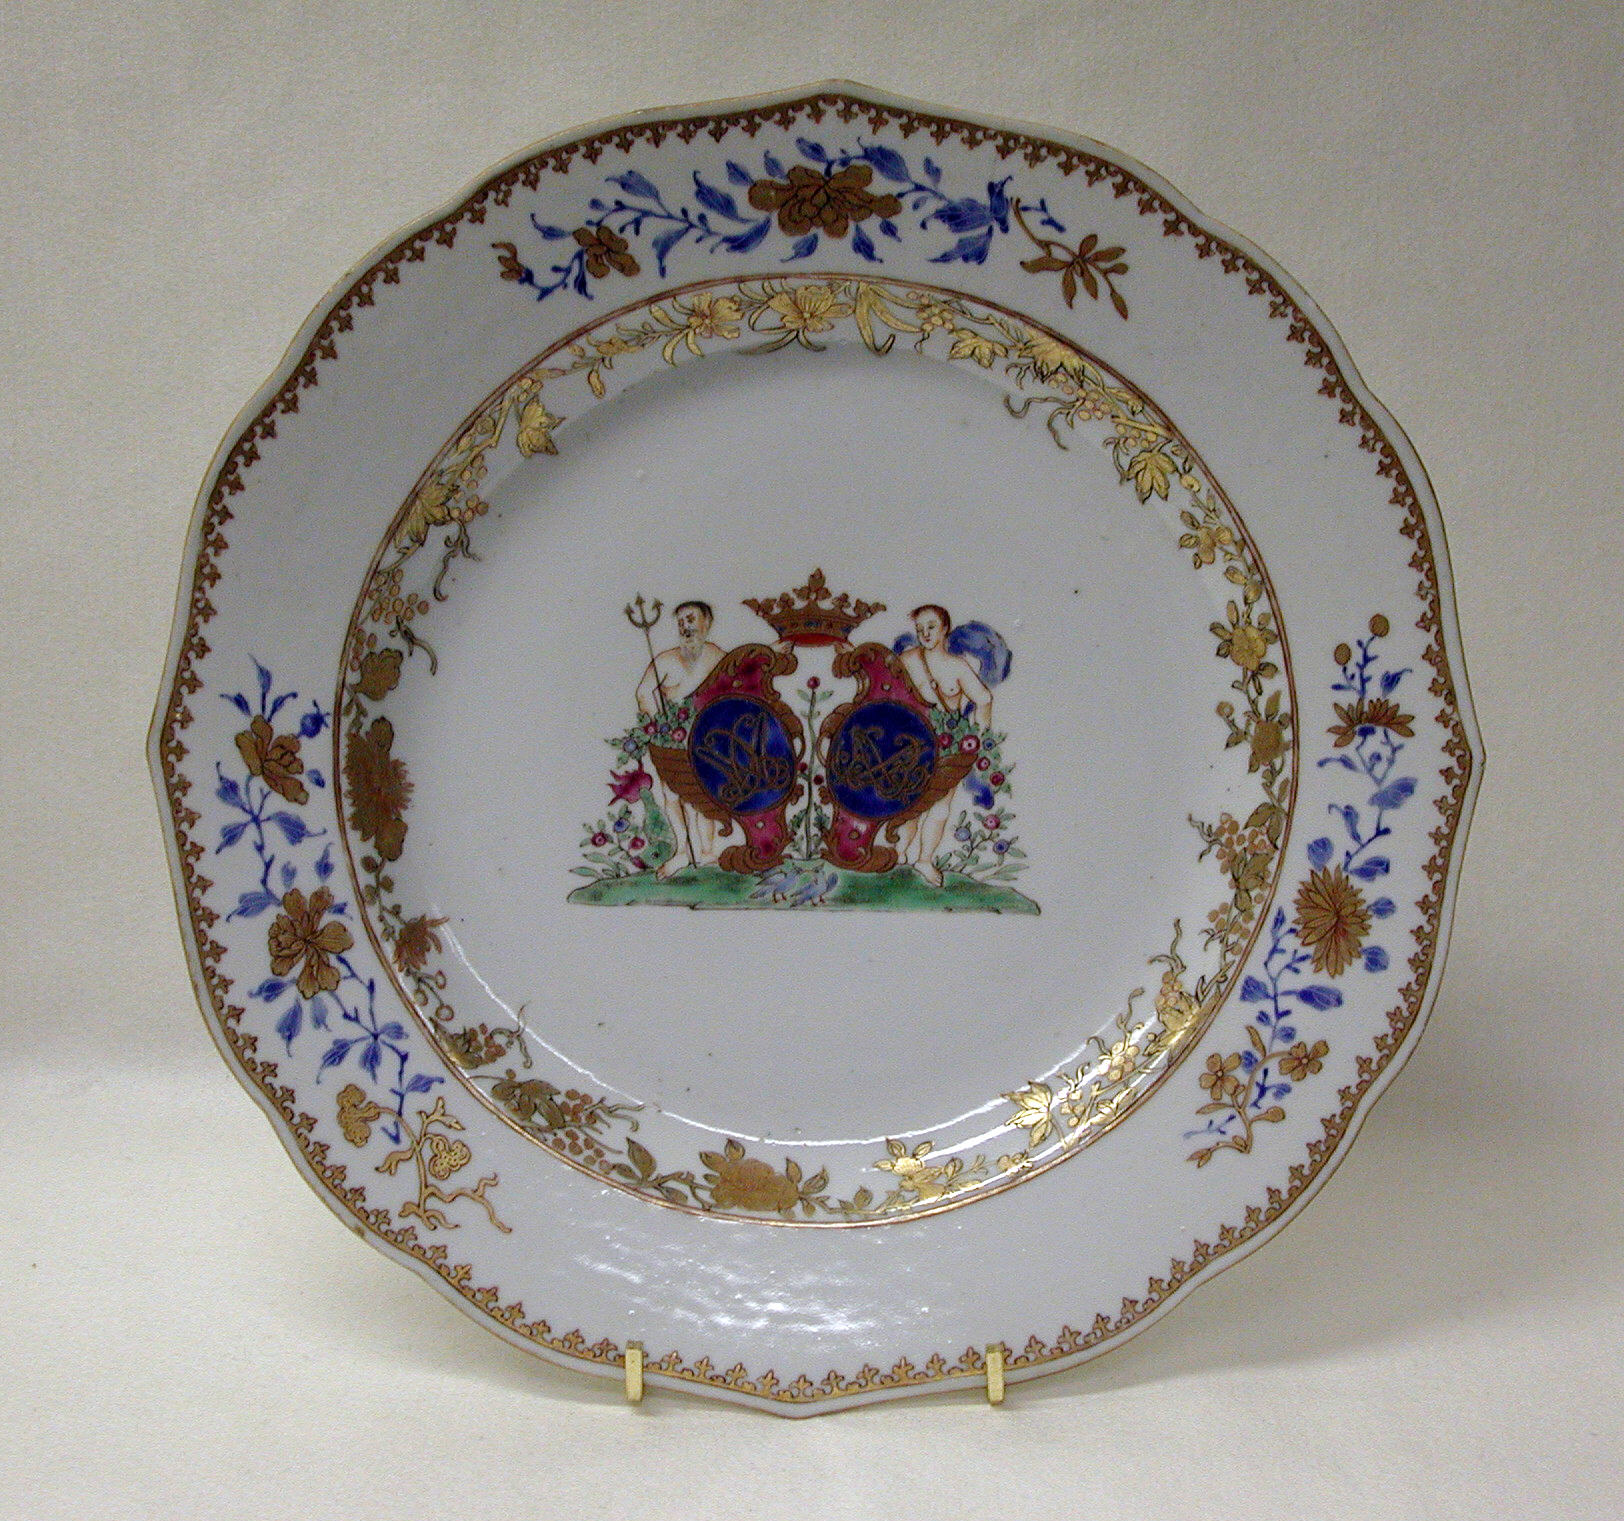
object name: plate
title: Plate (part of a service)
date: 1760-1770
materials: hard paste porcelain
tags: flowers,coat of arms